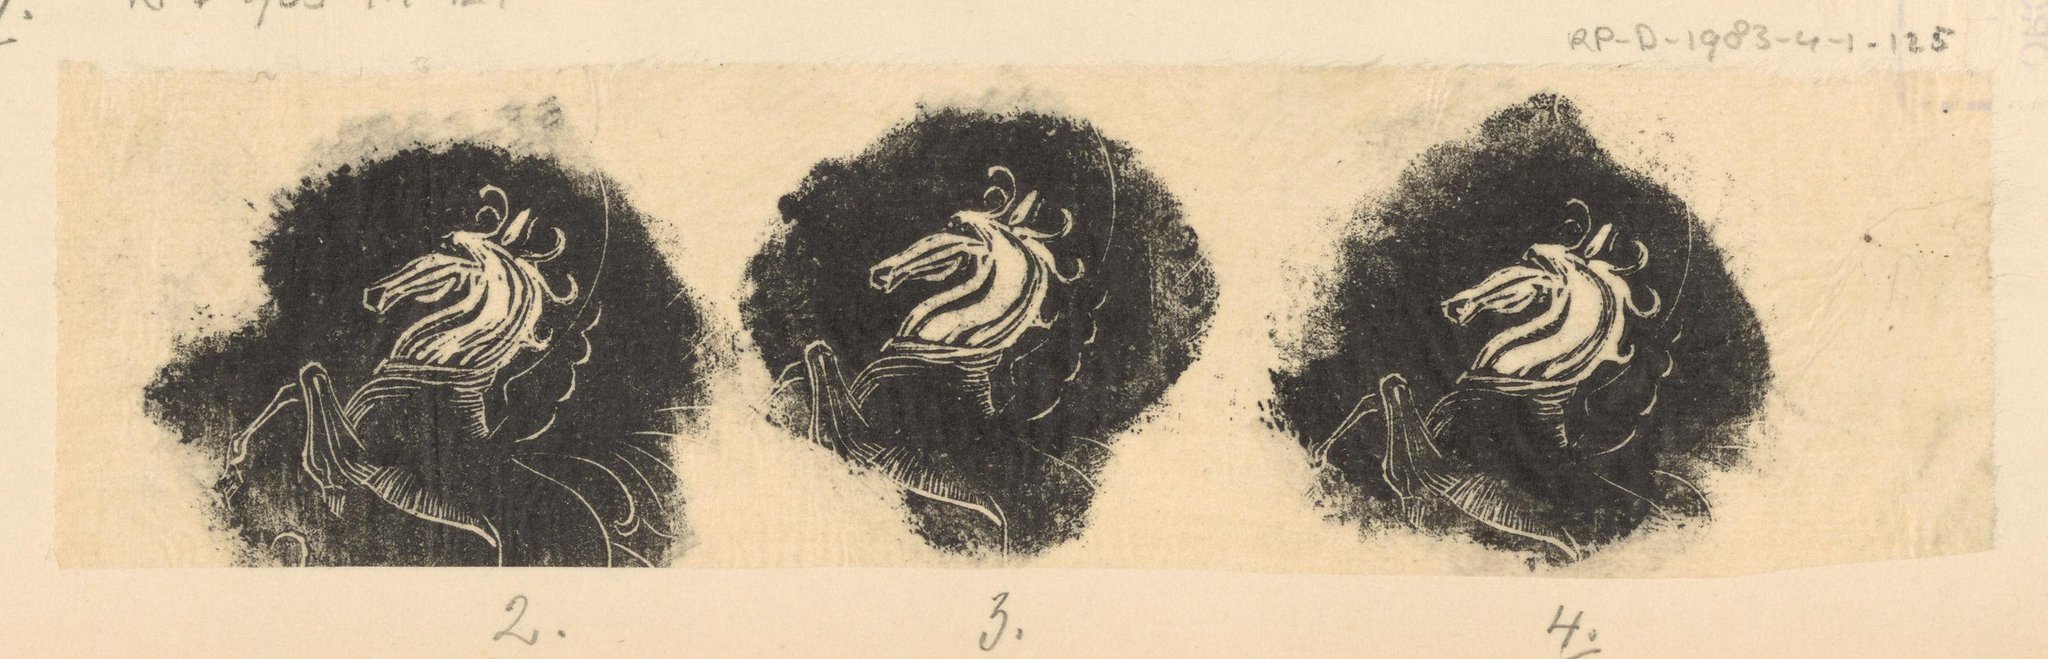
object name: bookplate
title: Blad met drie proefstaten van ex libris van Otto Verhagen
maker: otto verhagen (i)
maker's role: draughtsman, print maker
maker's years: 1885-1951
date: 1939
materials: paper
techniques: woodcut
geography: netherlands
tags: the hague, draughtsman, otto verhagen (i), (story of) cupid, amor (eros), horse